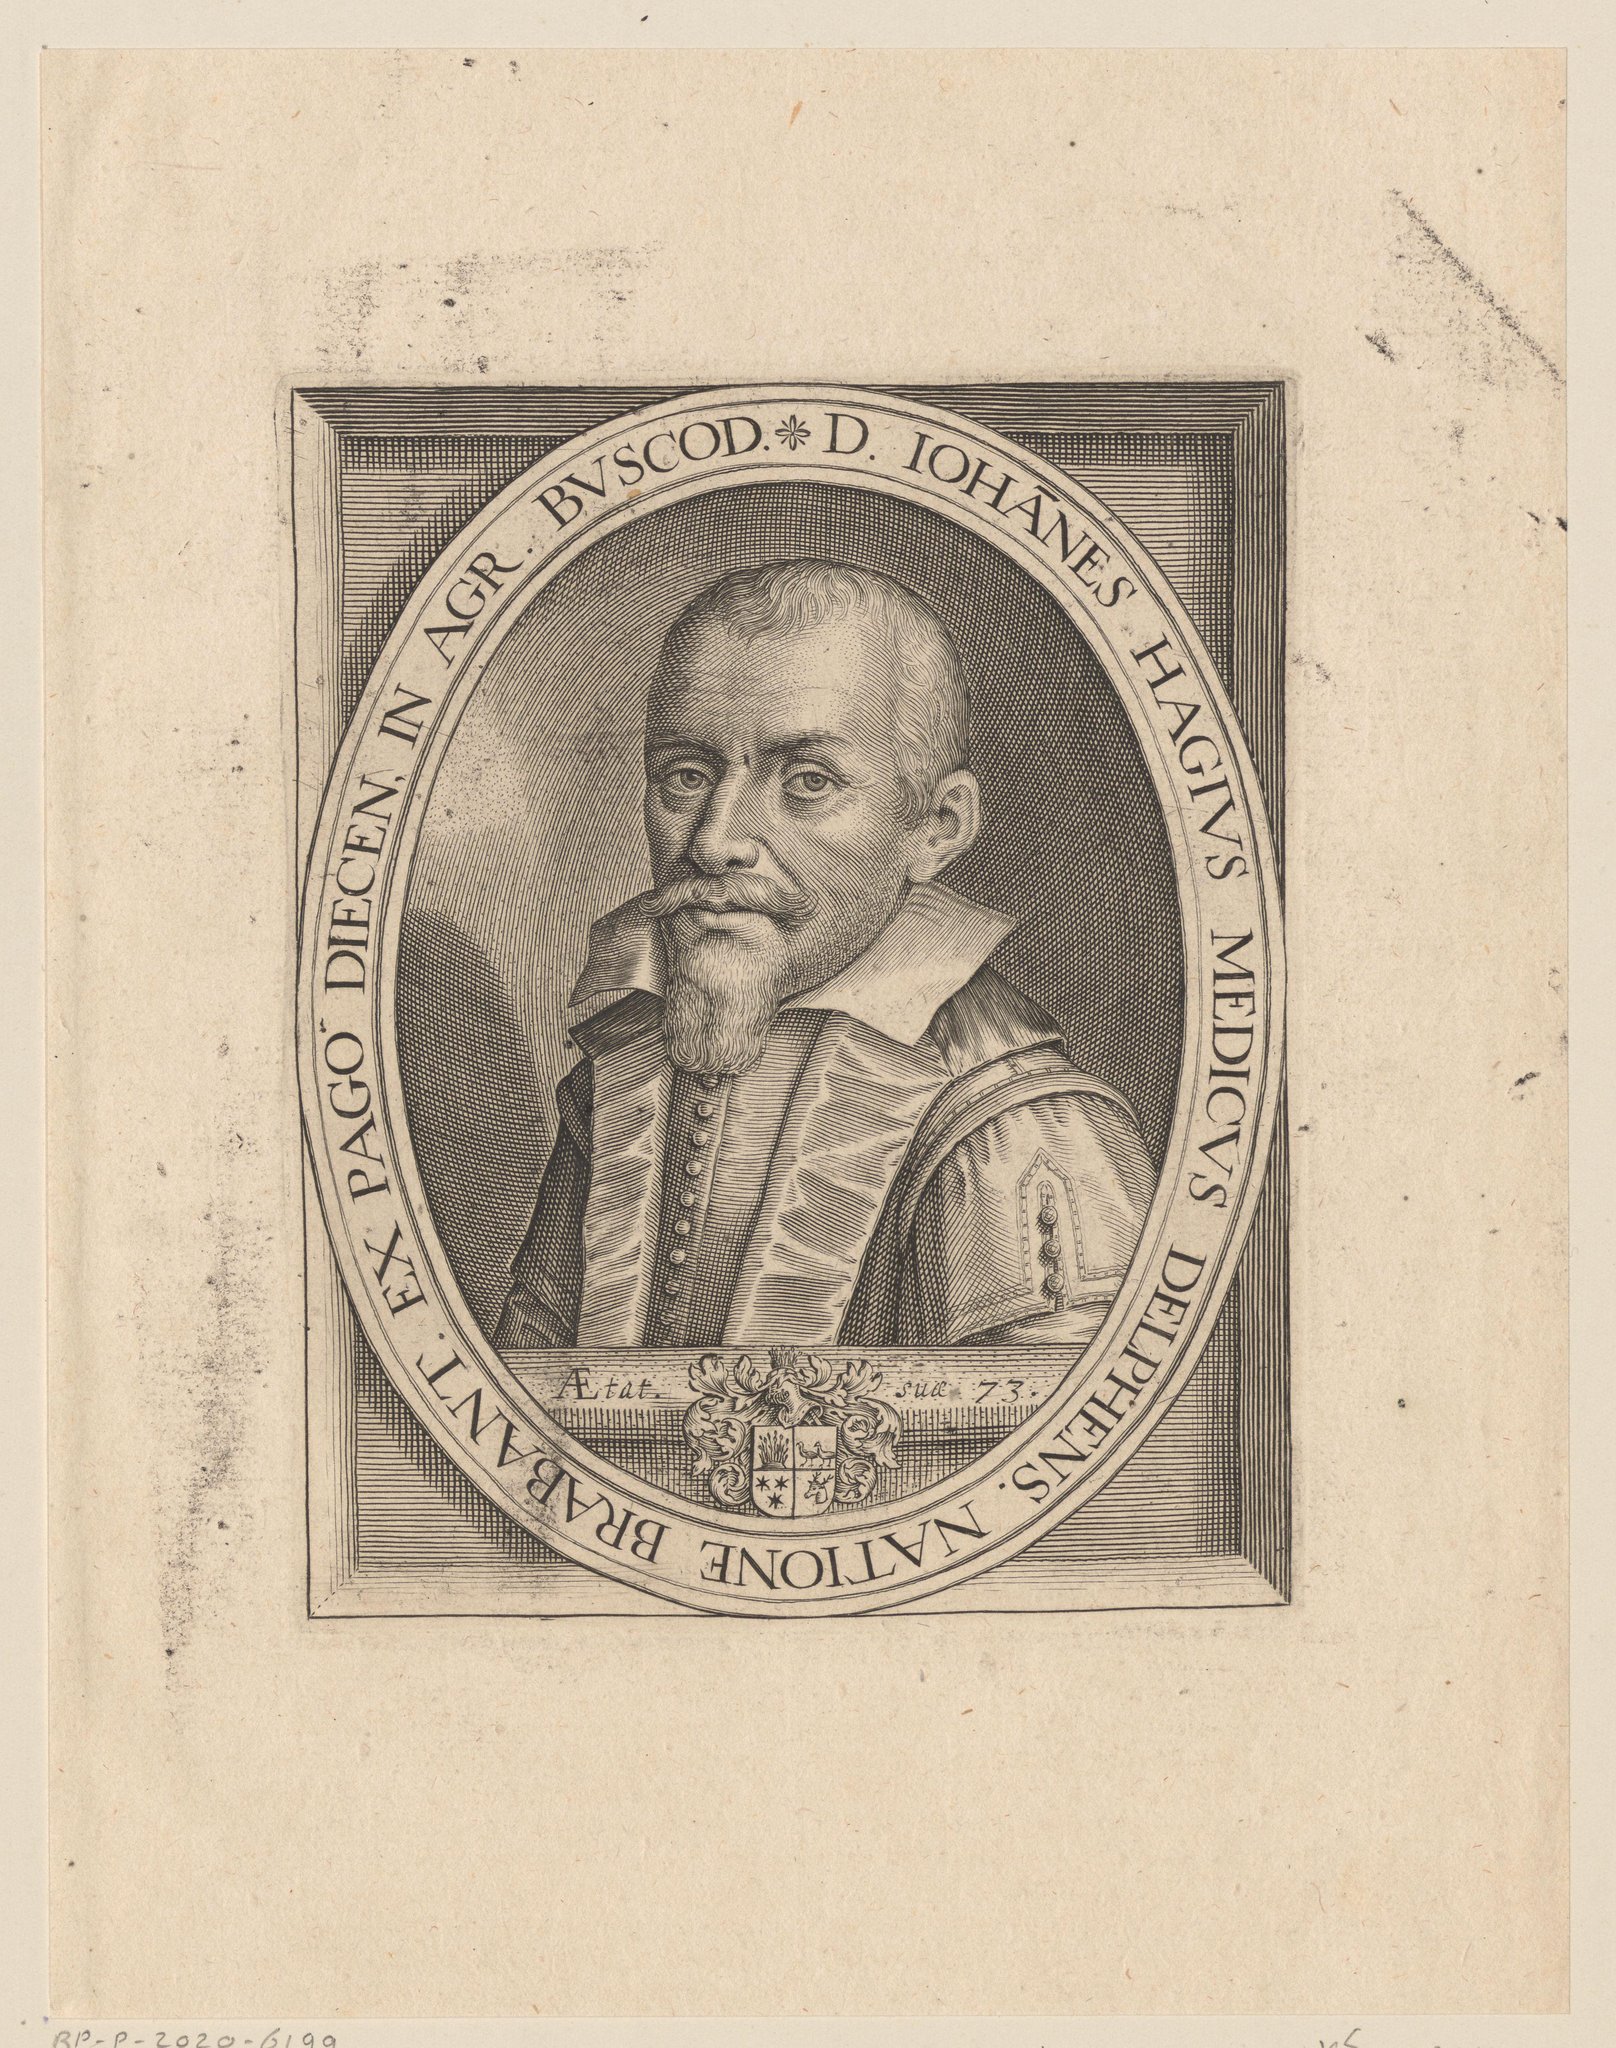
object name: print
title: Portret van Joannes Hagius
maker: Anonymous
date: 1600-1624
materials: paper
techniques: engraving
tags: delft, historical persons, physician, doctor, armorial bearing, heraldry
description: Prent met tekst op verso gebruikt in: Hagius, Joannes. Den lusthof der medecijnen (...). Dordrecht: Isaac Jansz. Canin, 1616.